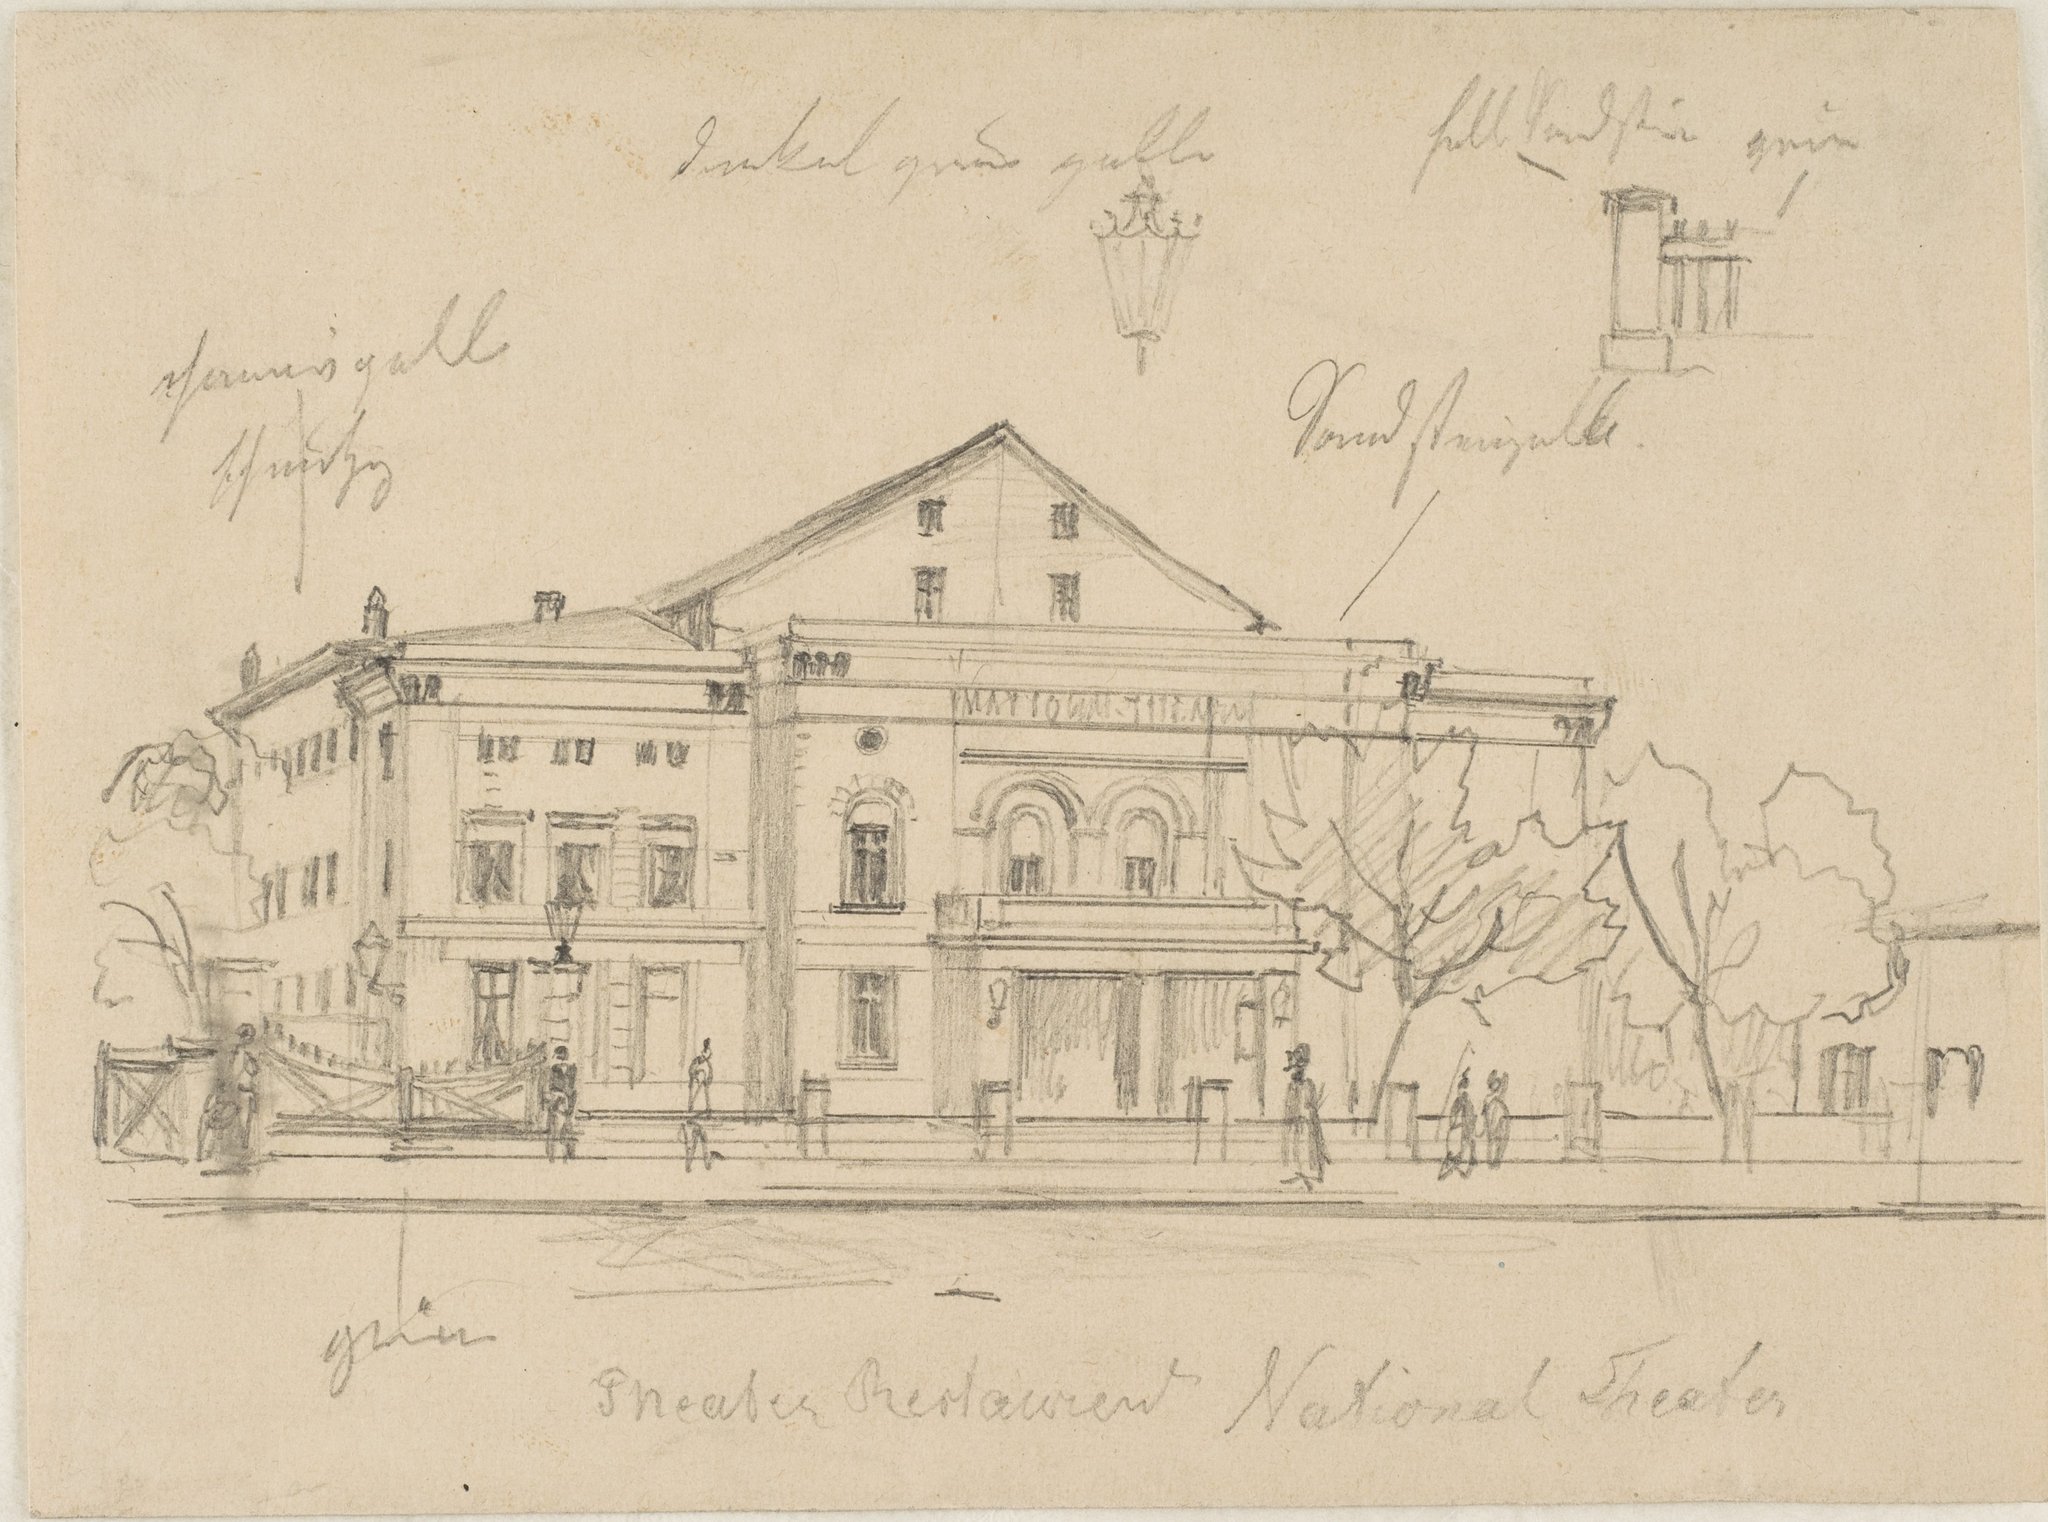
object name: drawing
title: Study of the Nationaltheater, Berlin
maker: eduard gaertner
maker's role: artist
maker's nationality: german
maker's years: 1801-1877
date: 1834-1866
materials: graphite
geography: germany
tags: theatre,architecture